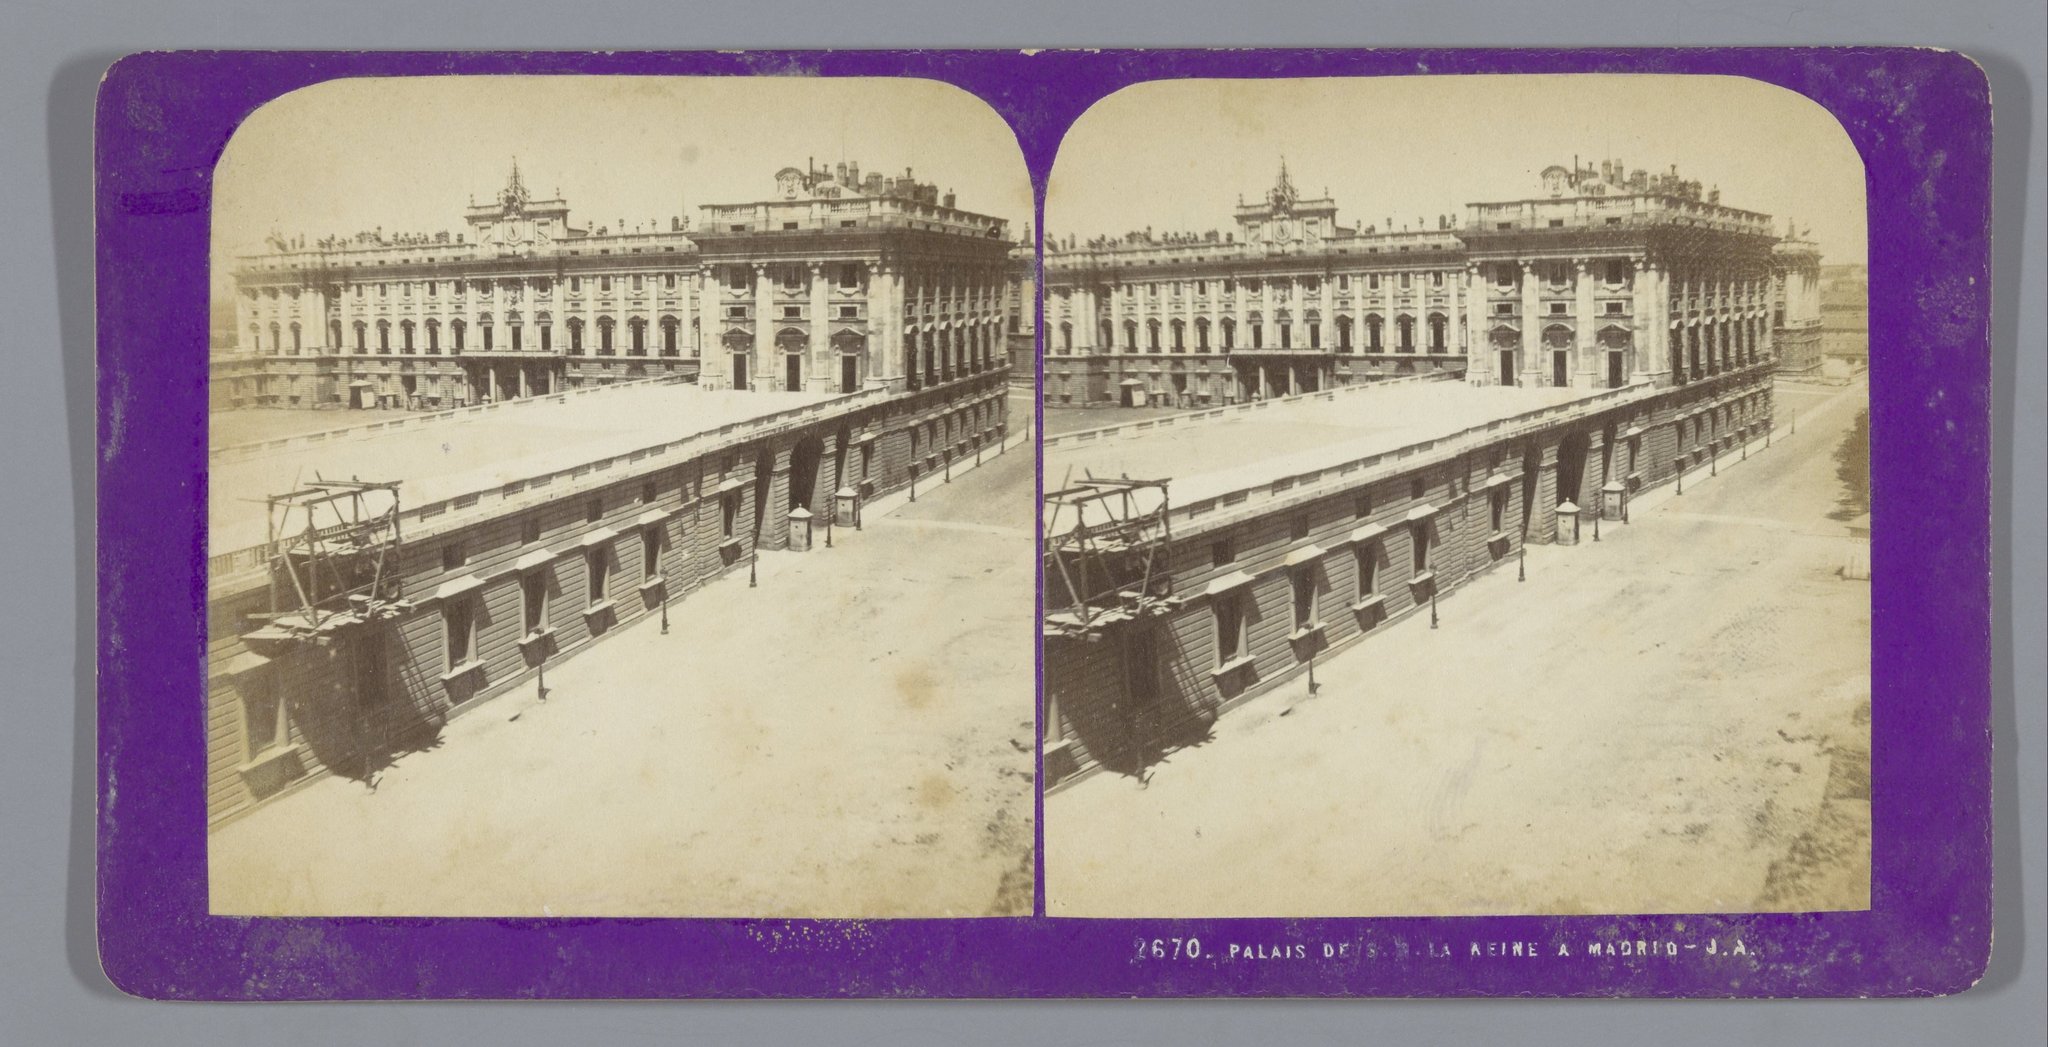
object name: stereograph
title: PALAIS DE S.M. LA REINE A MADRID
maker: jean andrieu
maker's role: fotograaf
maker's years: 1816-1872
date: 1862-1876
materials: cardboard, photographic support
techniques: albumen print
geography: madrid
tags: palace, façade (of house or building)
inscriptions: number: ‘2670.’